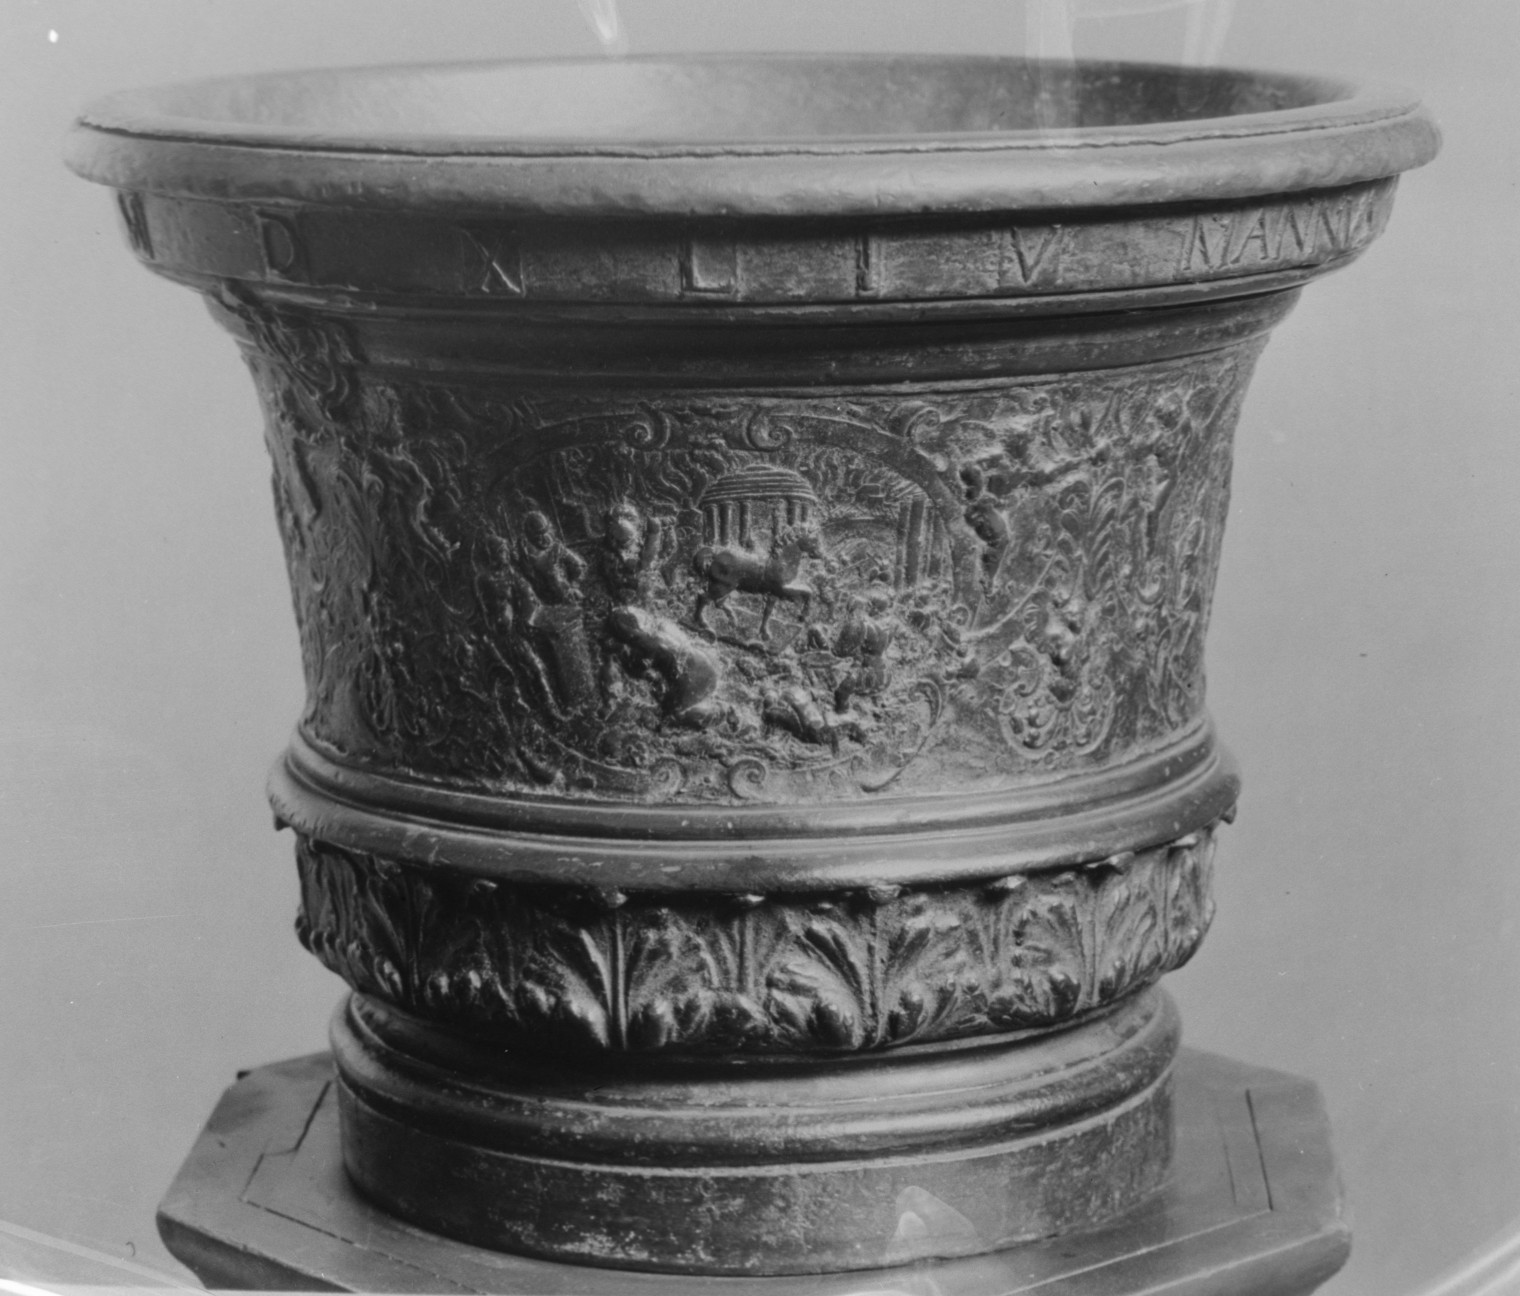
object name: mortar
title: Sixteenth-century-style mortar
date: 1801-1900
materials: bronze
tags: horses